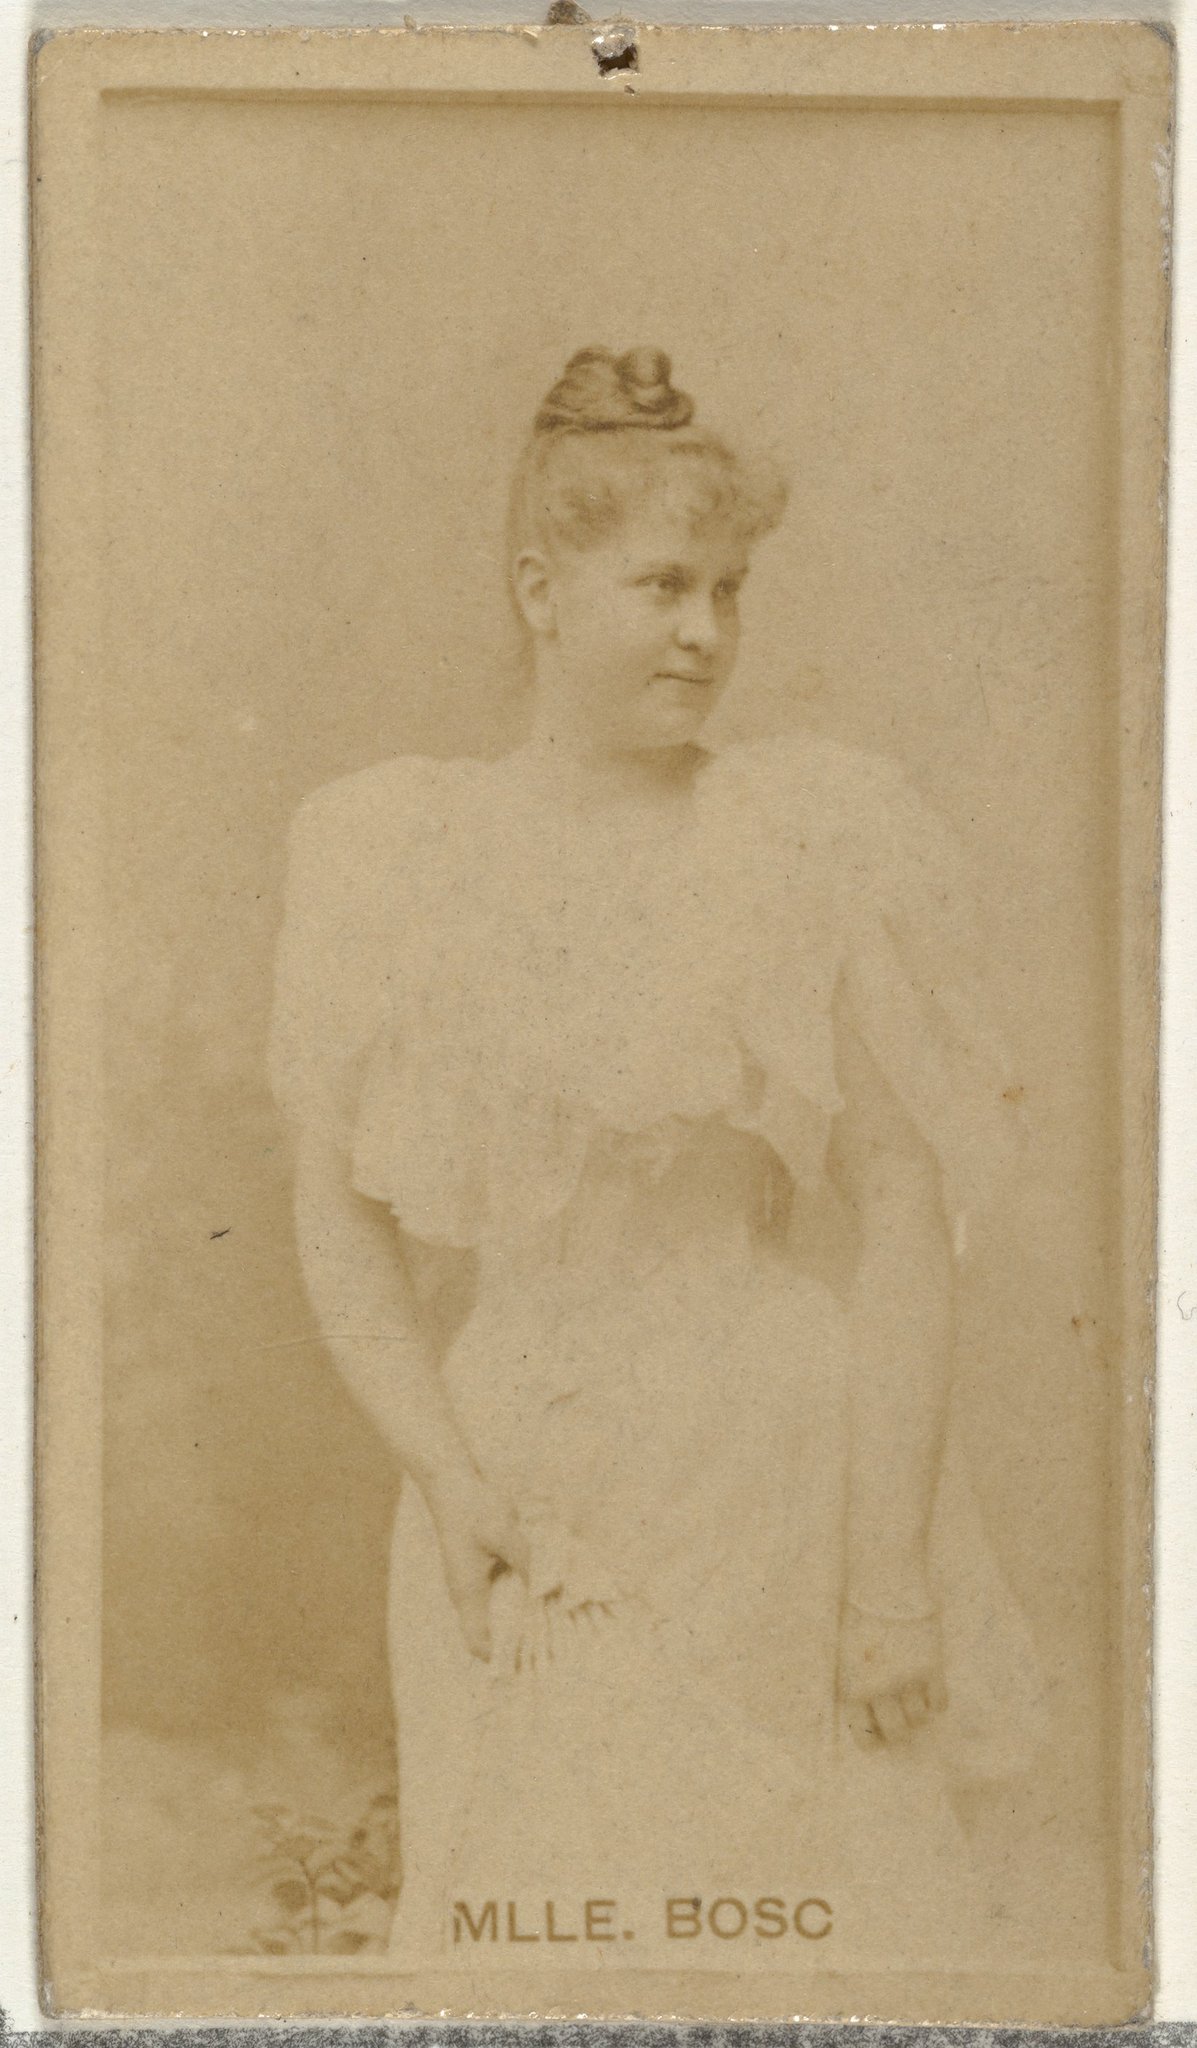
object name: photograph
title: Mlle. Bosc, from the Actors and Actresses series (N145-8) issued by Duke Sons & Co. to promote Duke Cigarettes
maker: w. duke, sons & co.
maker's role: publisher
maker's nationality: american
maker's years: 1870-1920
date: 1891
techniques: albumen silver print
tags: portraits,women,actresses